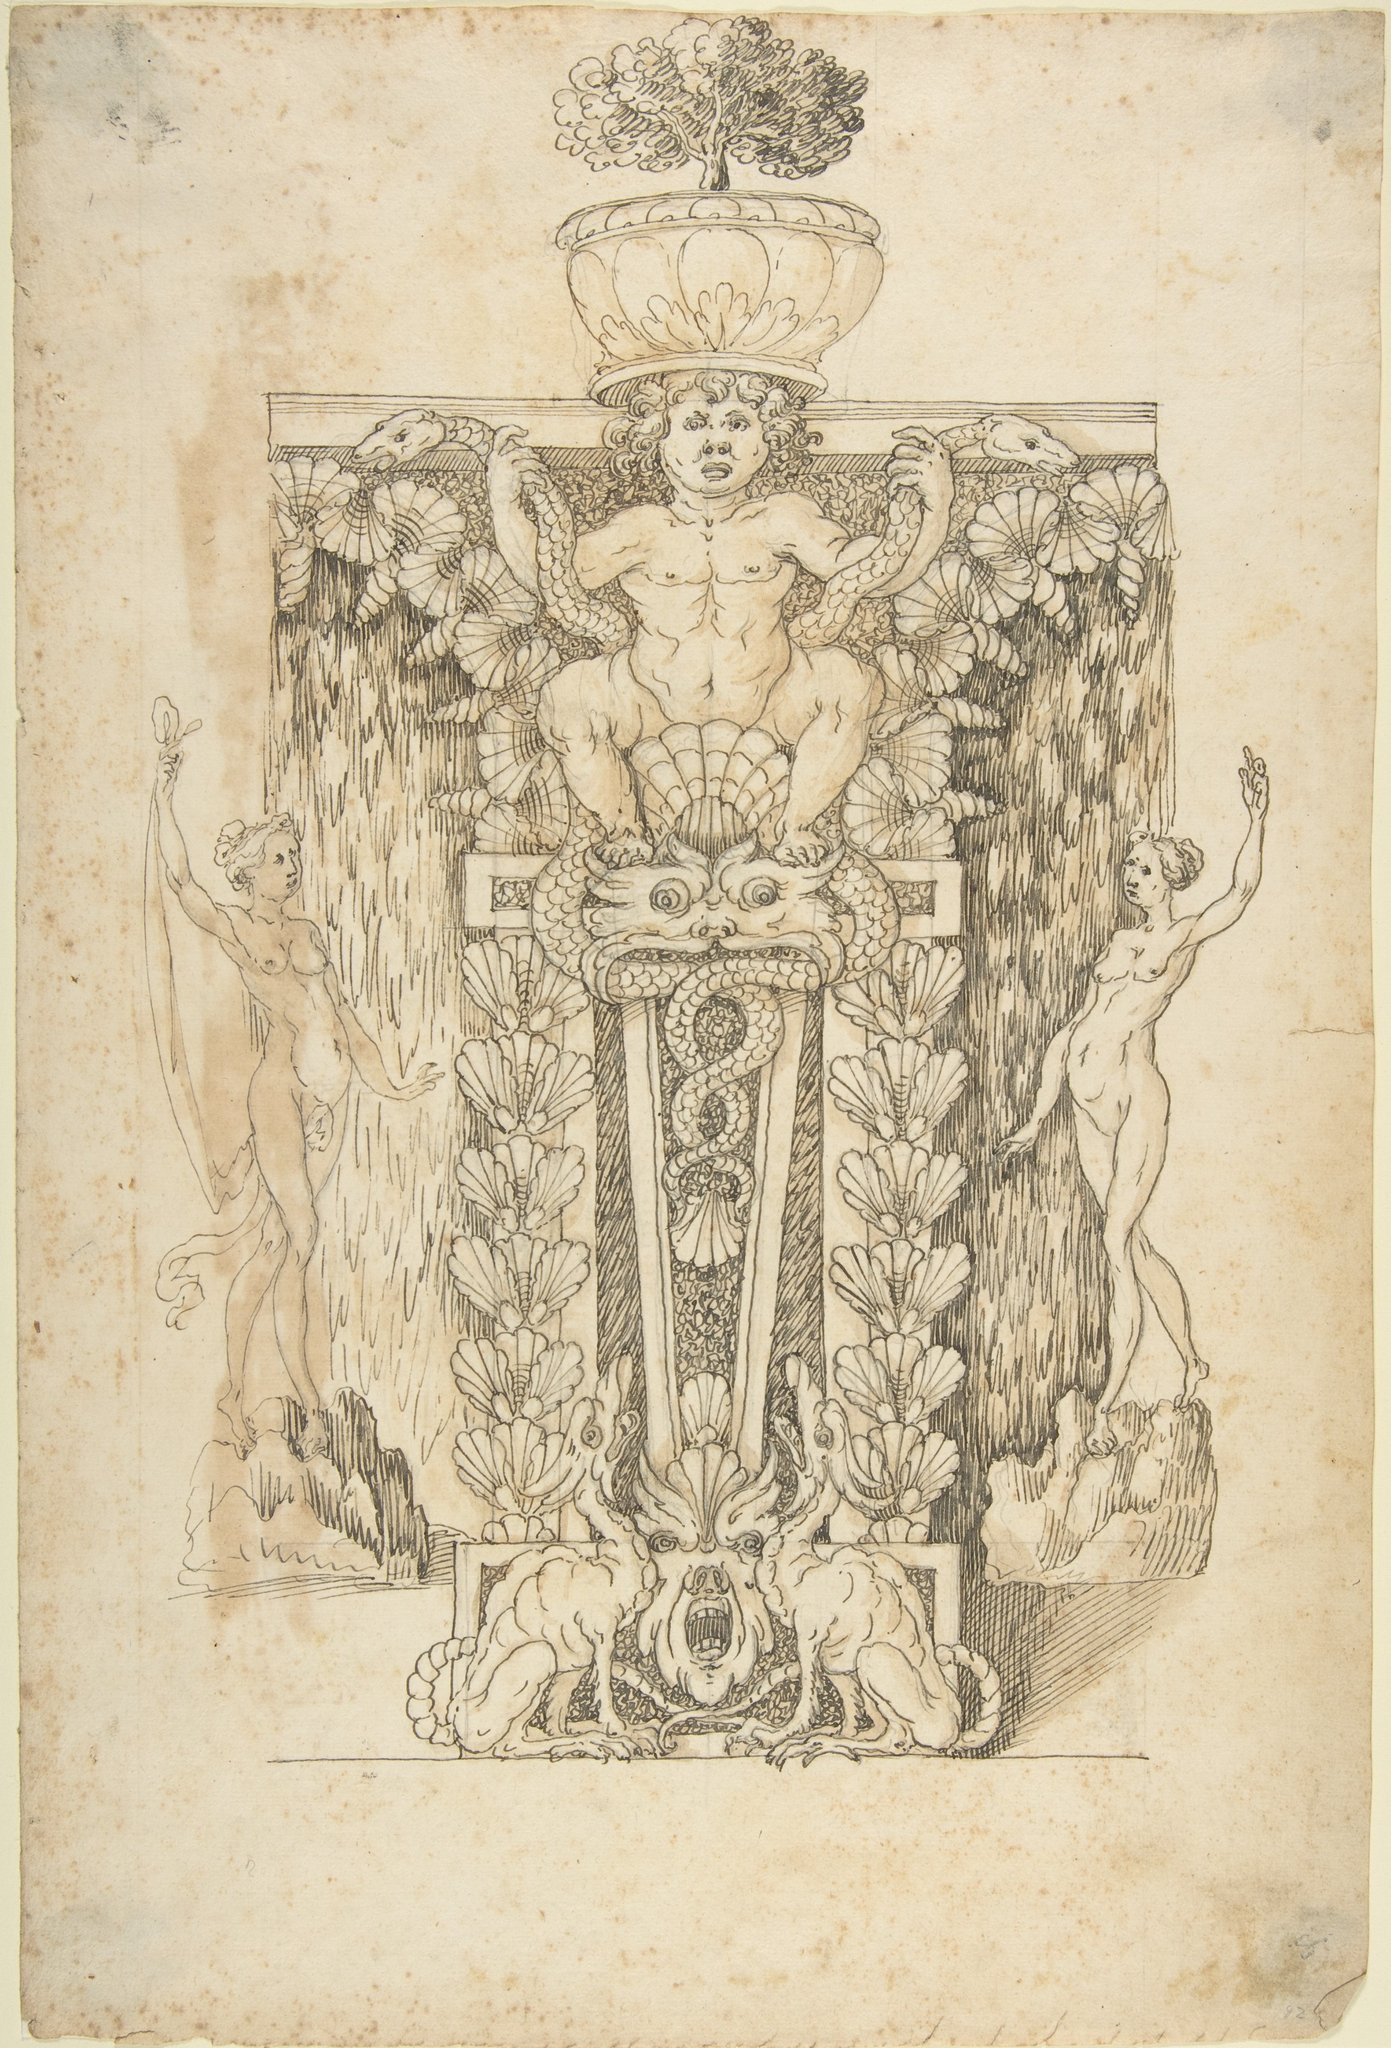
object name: drawing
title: Design for a Wall Fountain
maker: anonymous, italian, lombard, 16th century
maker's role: artist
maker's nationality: italian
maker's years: 1500-1600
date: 1550-1620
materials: graphite, ink, drawing material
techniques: pen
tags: female nudes,snakes